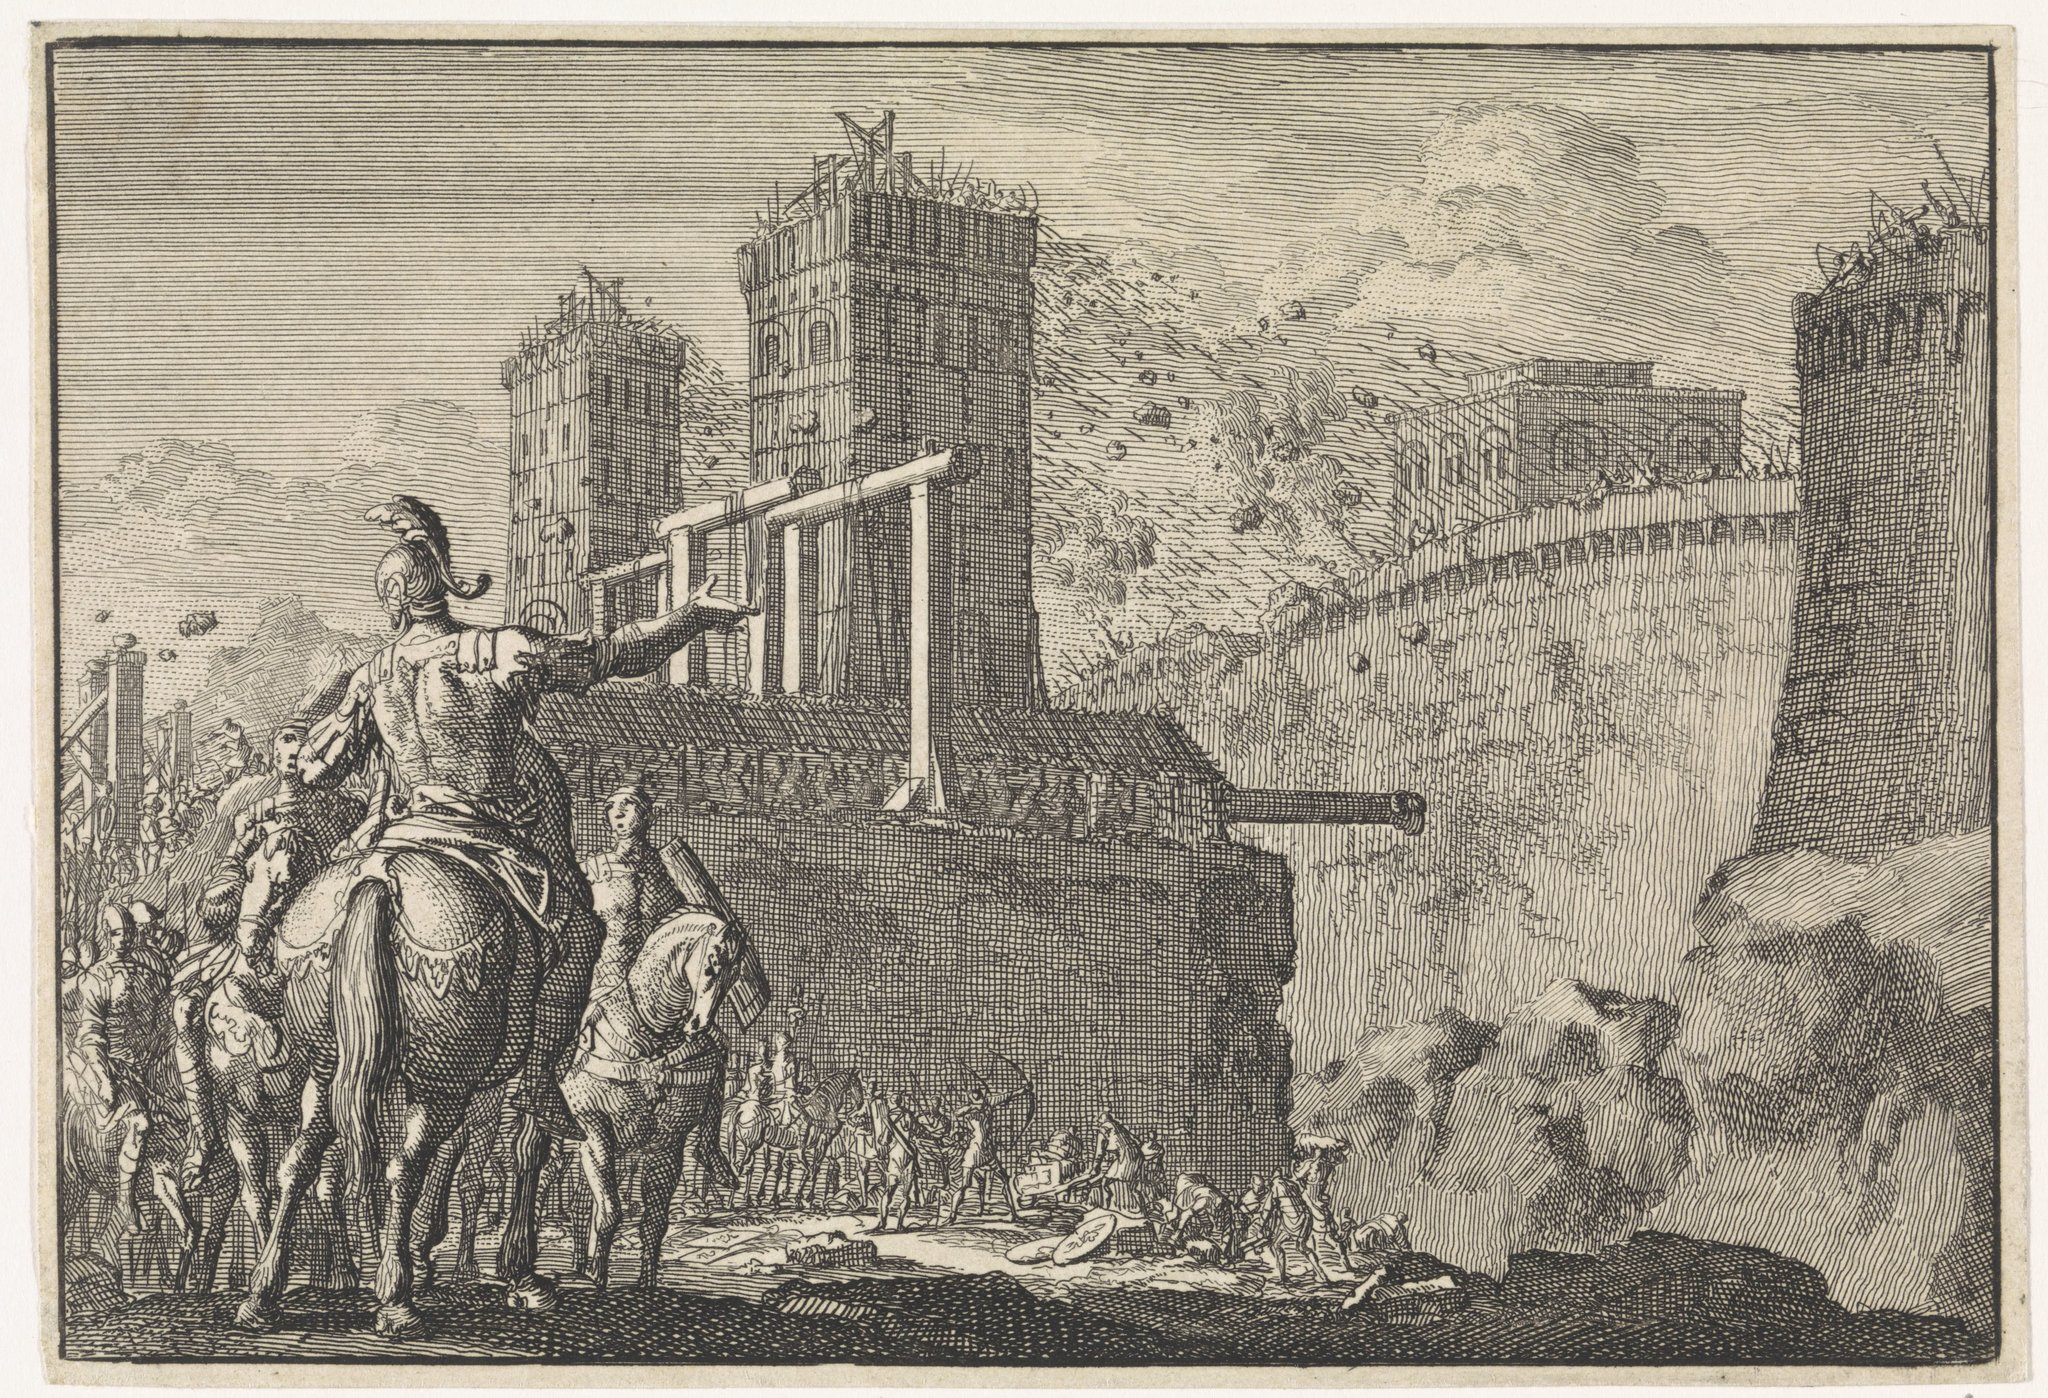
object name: print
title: Beleg van Jeruzalem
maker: jan luyken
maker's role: draughtsman, print maker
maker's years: 1649-1712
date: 1704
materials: paper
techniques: etching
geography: amsterdam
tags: siege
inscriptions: collector's mark: Lugt 2228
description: Prent ook gebruikt als boekillustratie in: Josephus, Flavius. Alle de Werken, 2 delen. Amsterdam: Pieter Mortier, 1704, dl. 2, p. 662.